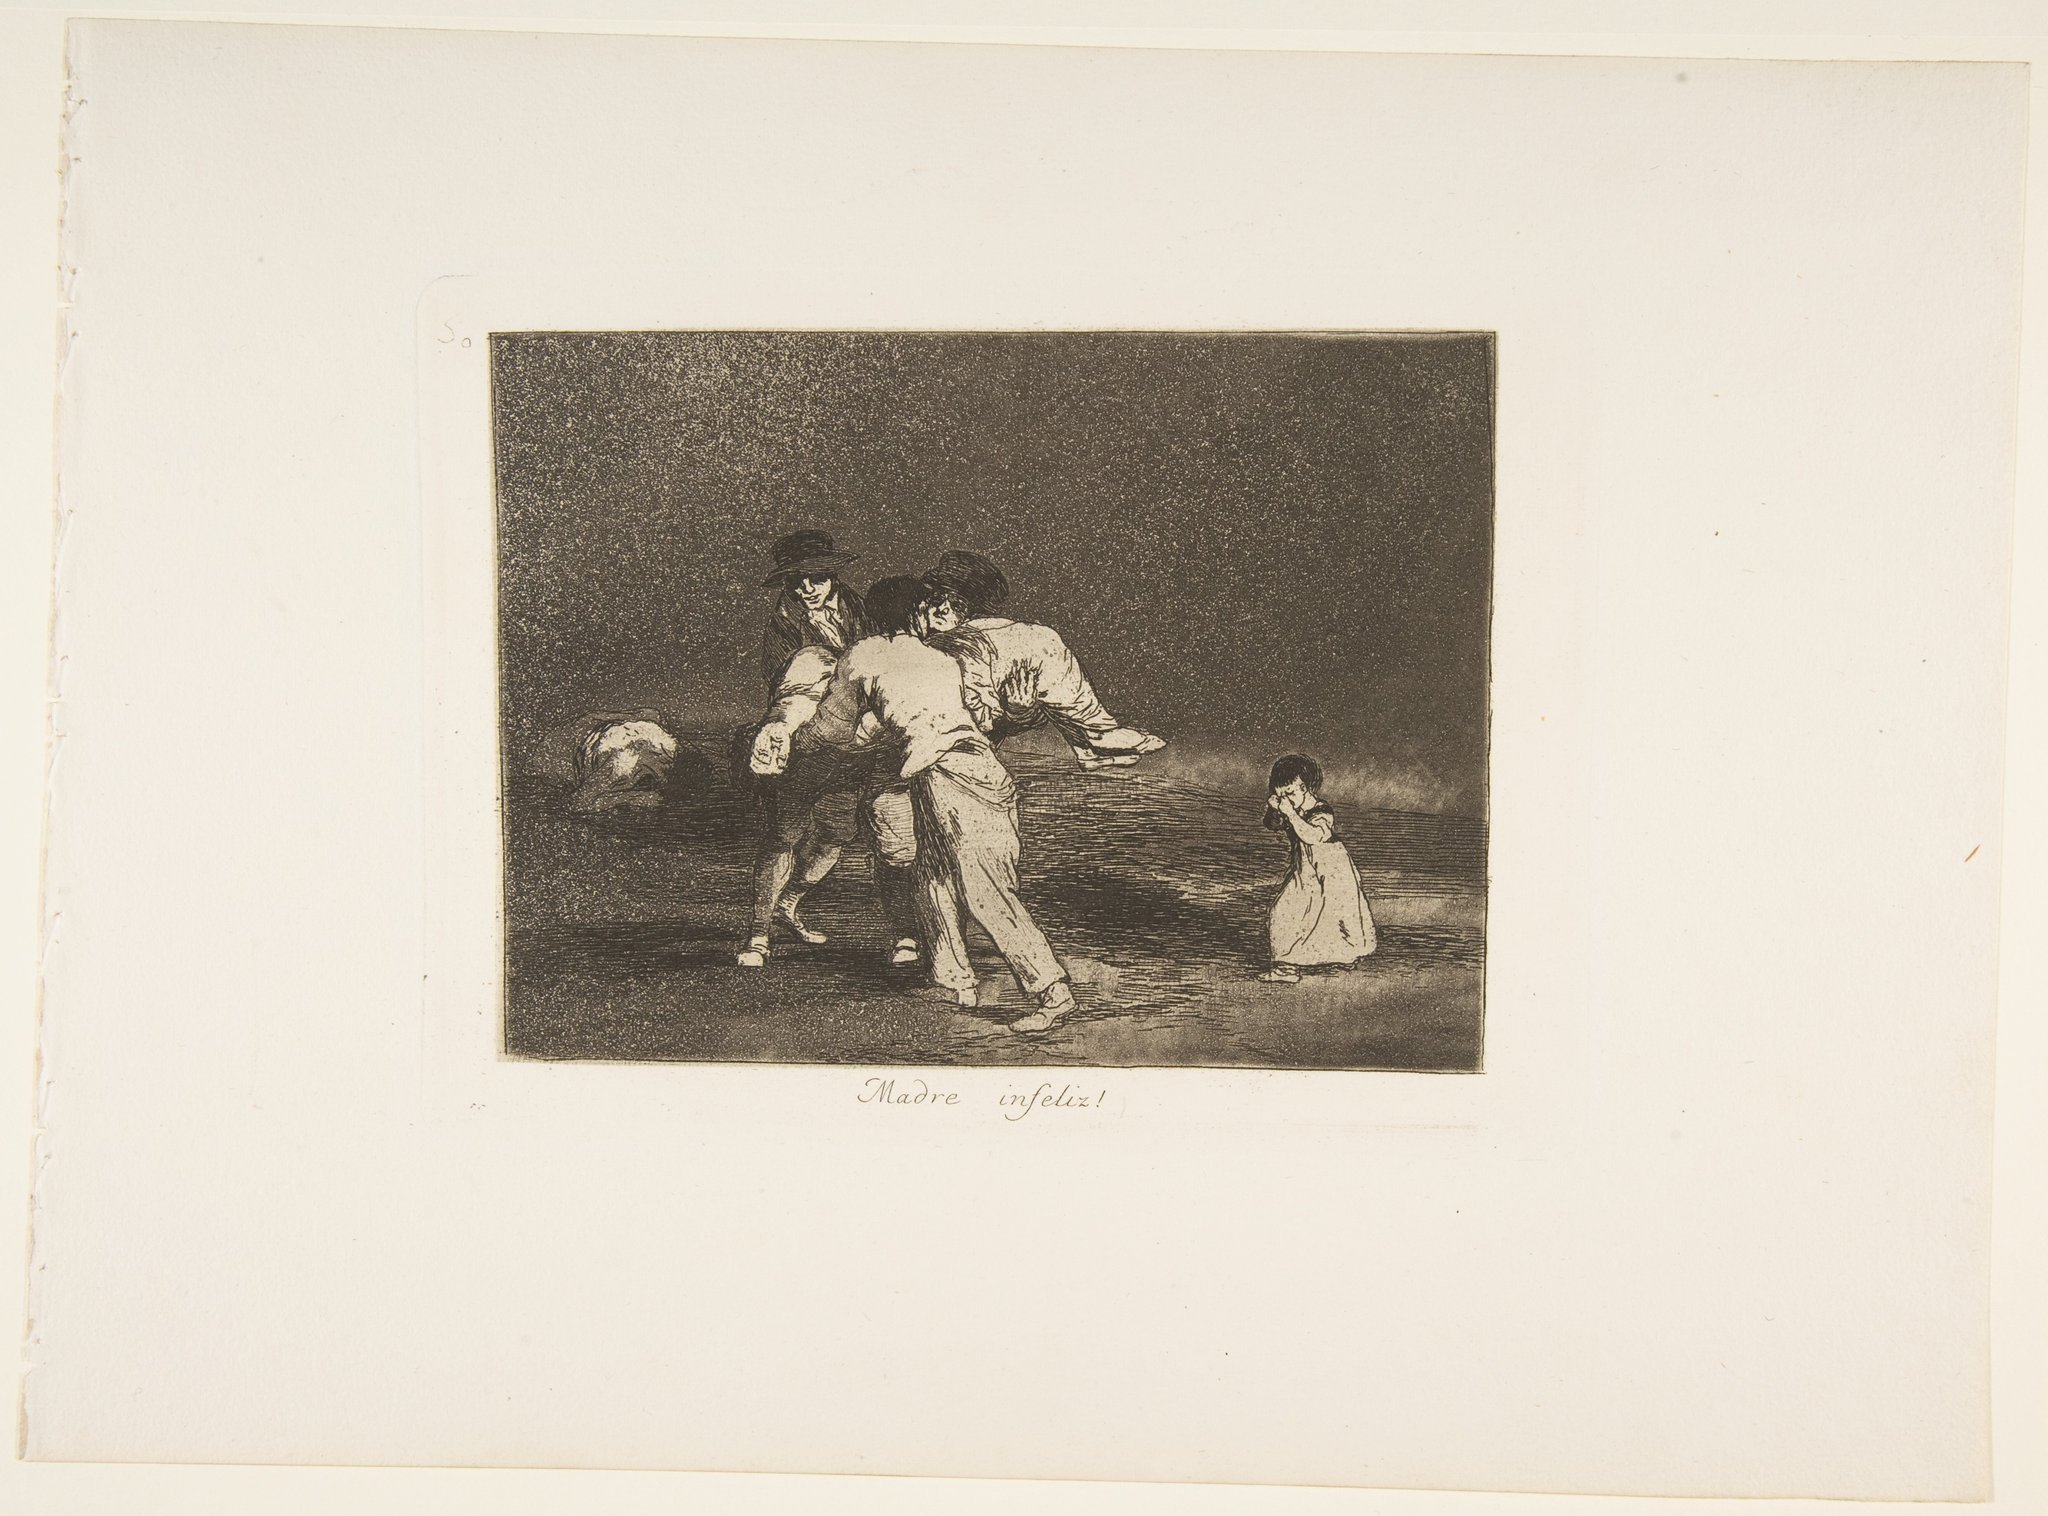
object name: print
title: Plate 50 from "The Disasters of War" (Los Desastres de la Guerra): 'Unhappy mother!' (Madre Infeliz!)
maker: goya (francisco de goya y lucientes)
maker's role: artist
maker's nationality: spanish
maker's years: 1746-1828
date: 1811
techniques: aquatint, burnishing, drypoint, etching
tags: children,men,women